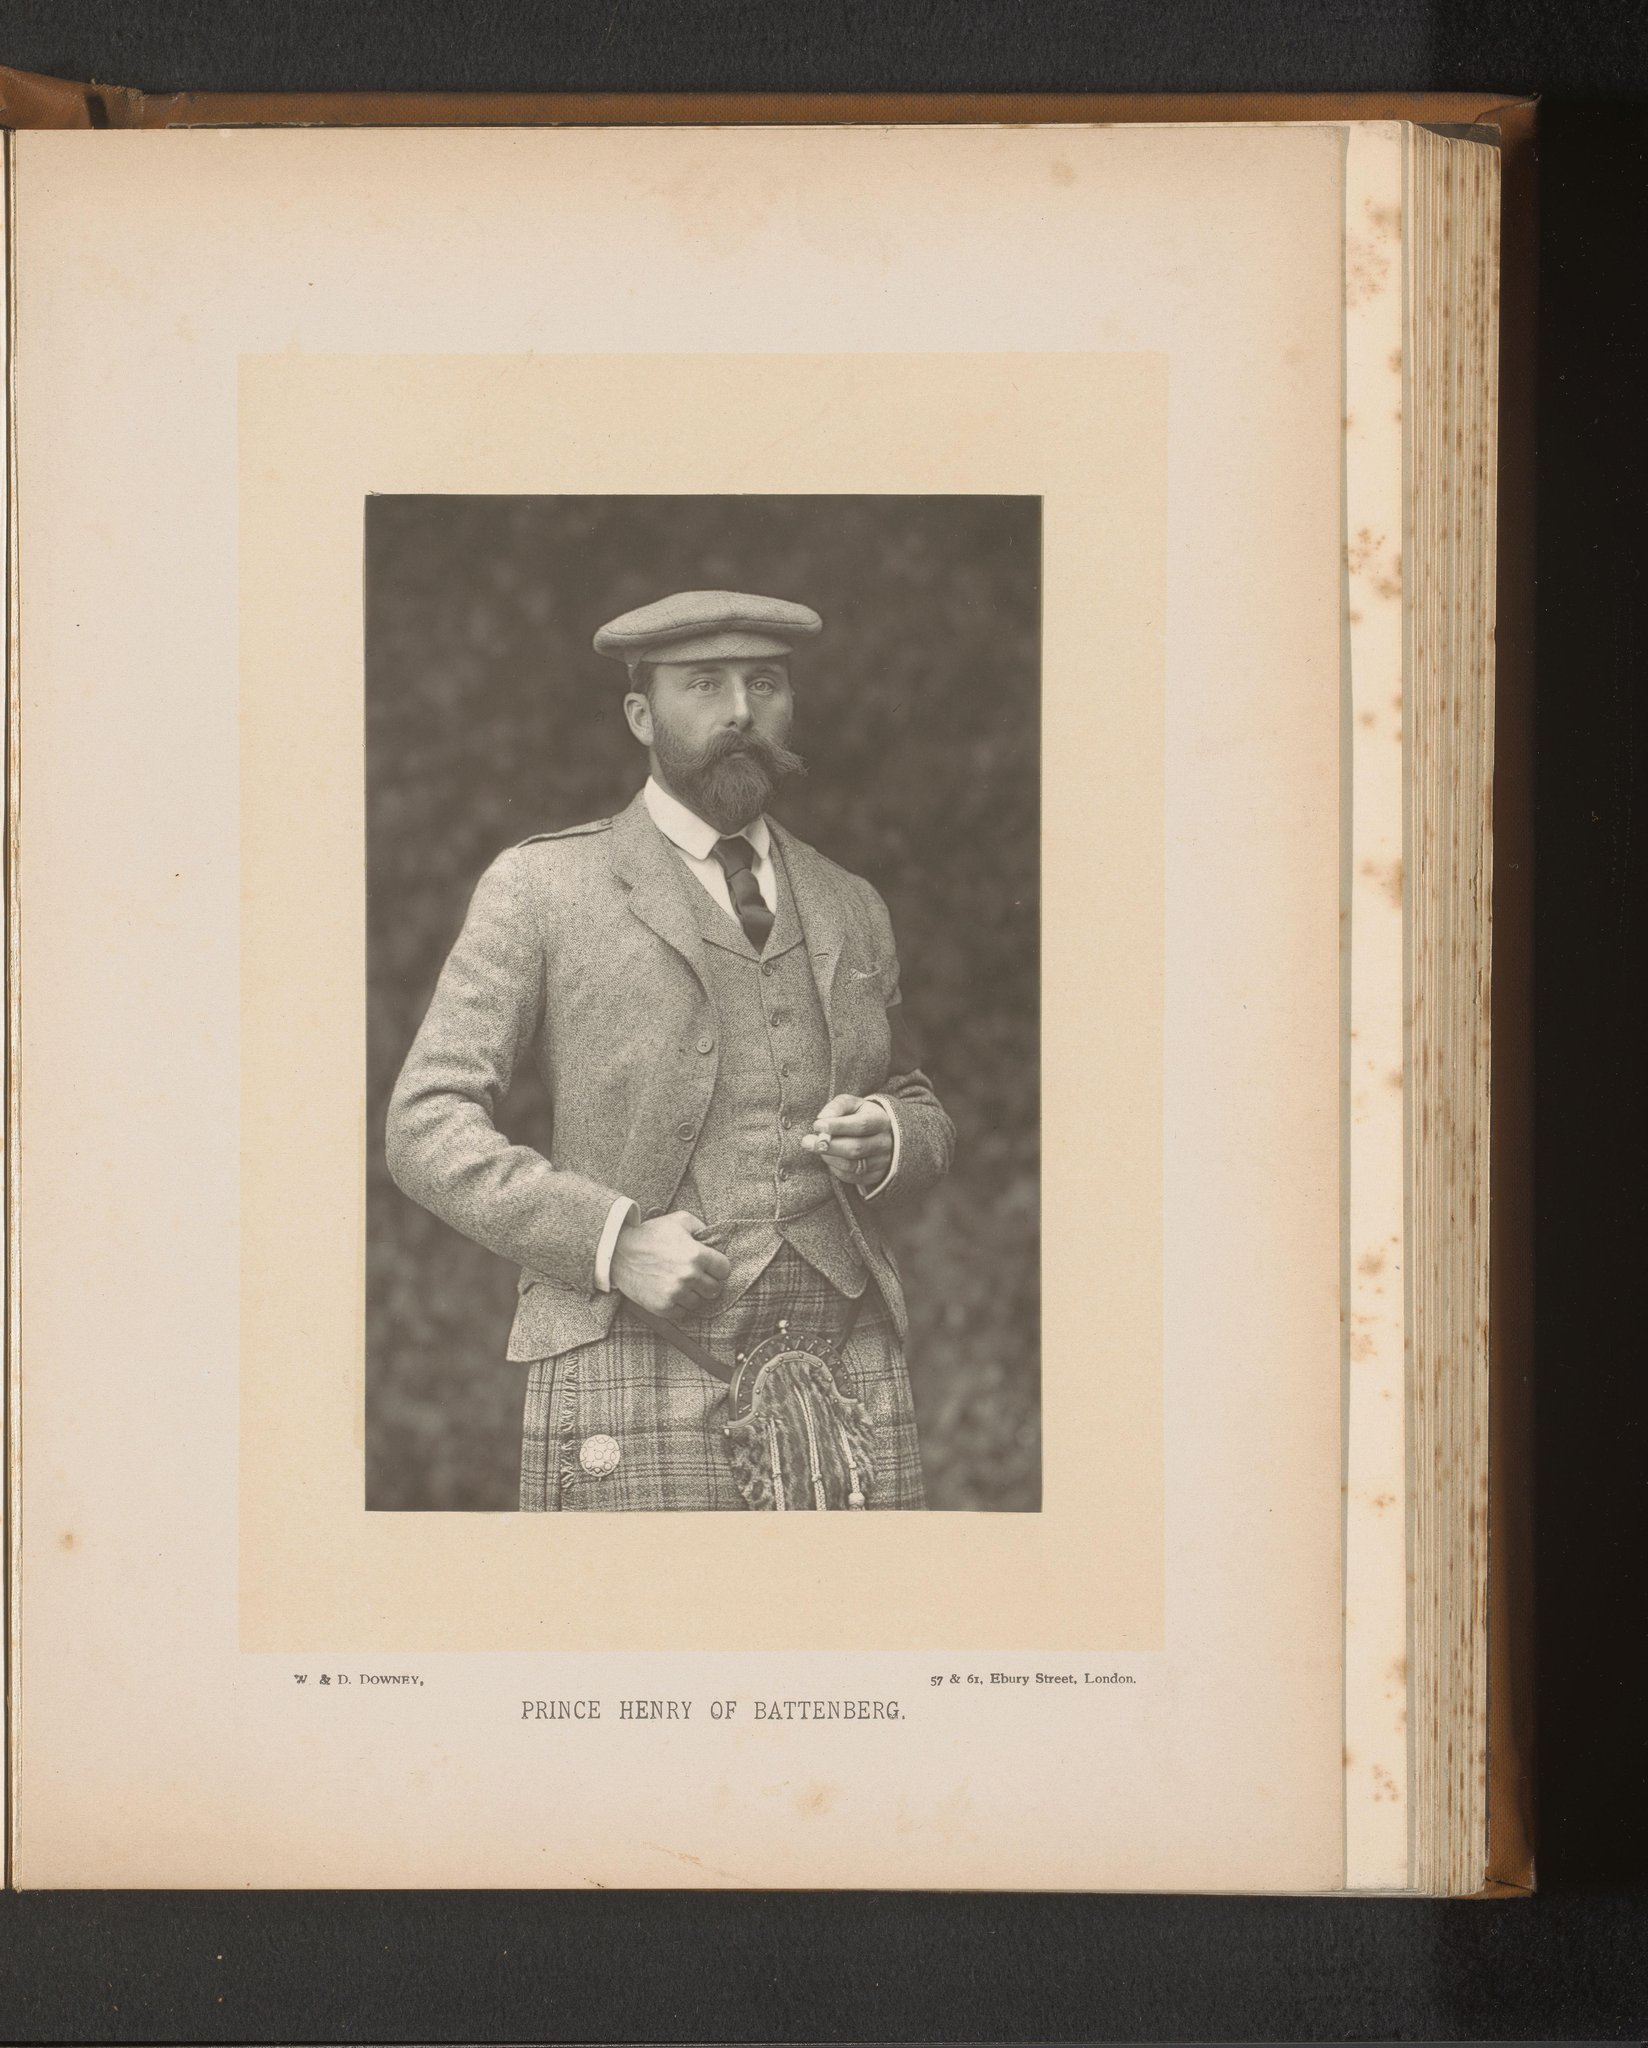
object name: photomechanical print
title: Portret van Henry van Battenberg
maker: Anonymous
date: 1884-1894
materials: paper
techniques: woodburytype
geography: london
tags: prince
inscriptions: inscription: ‘57 & 61, Elbury Street, London.’